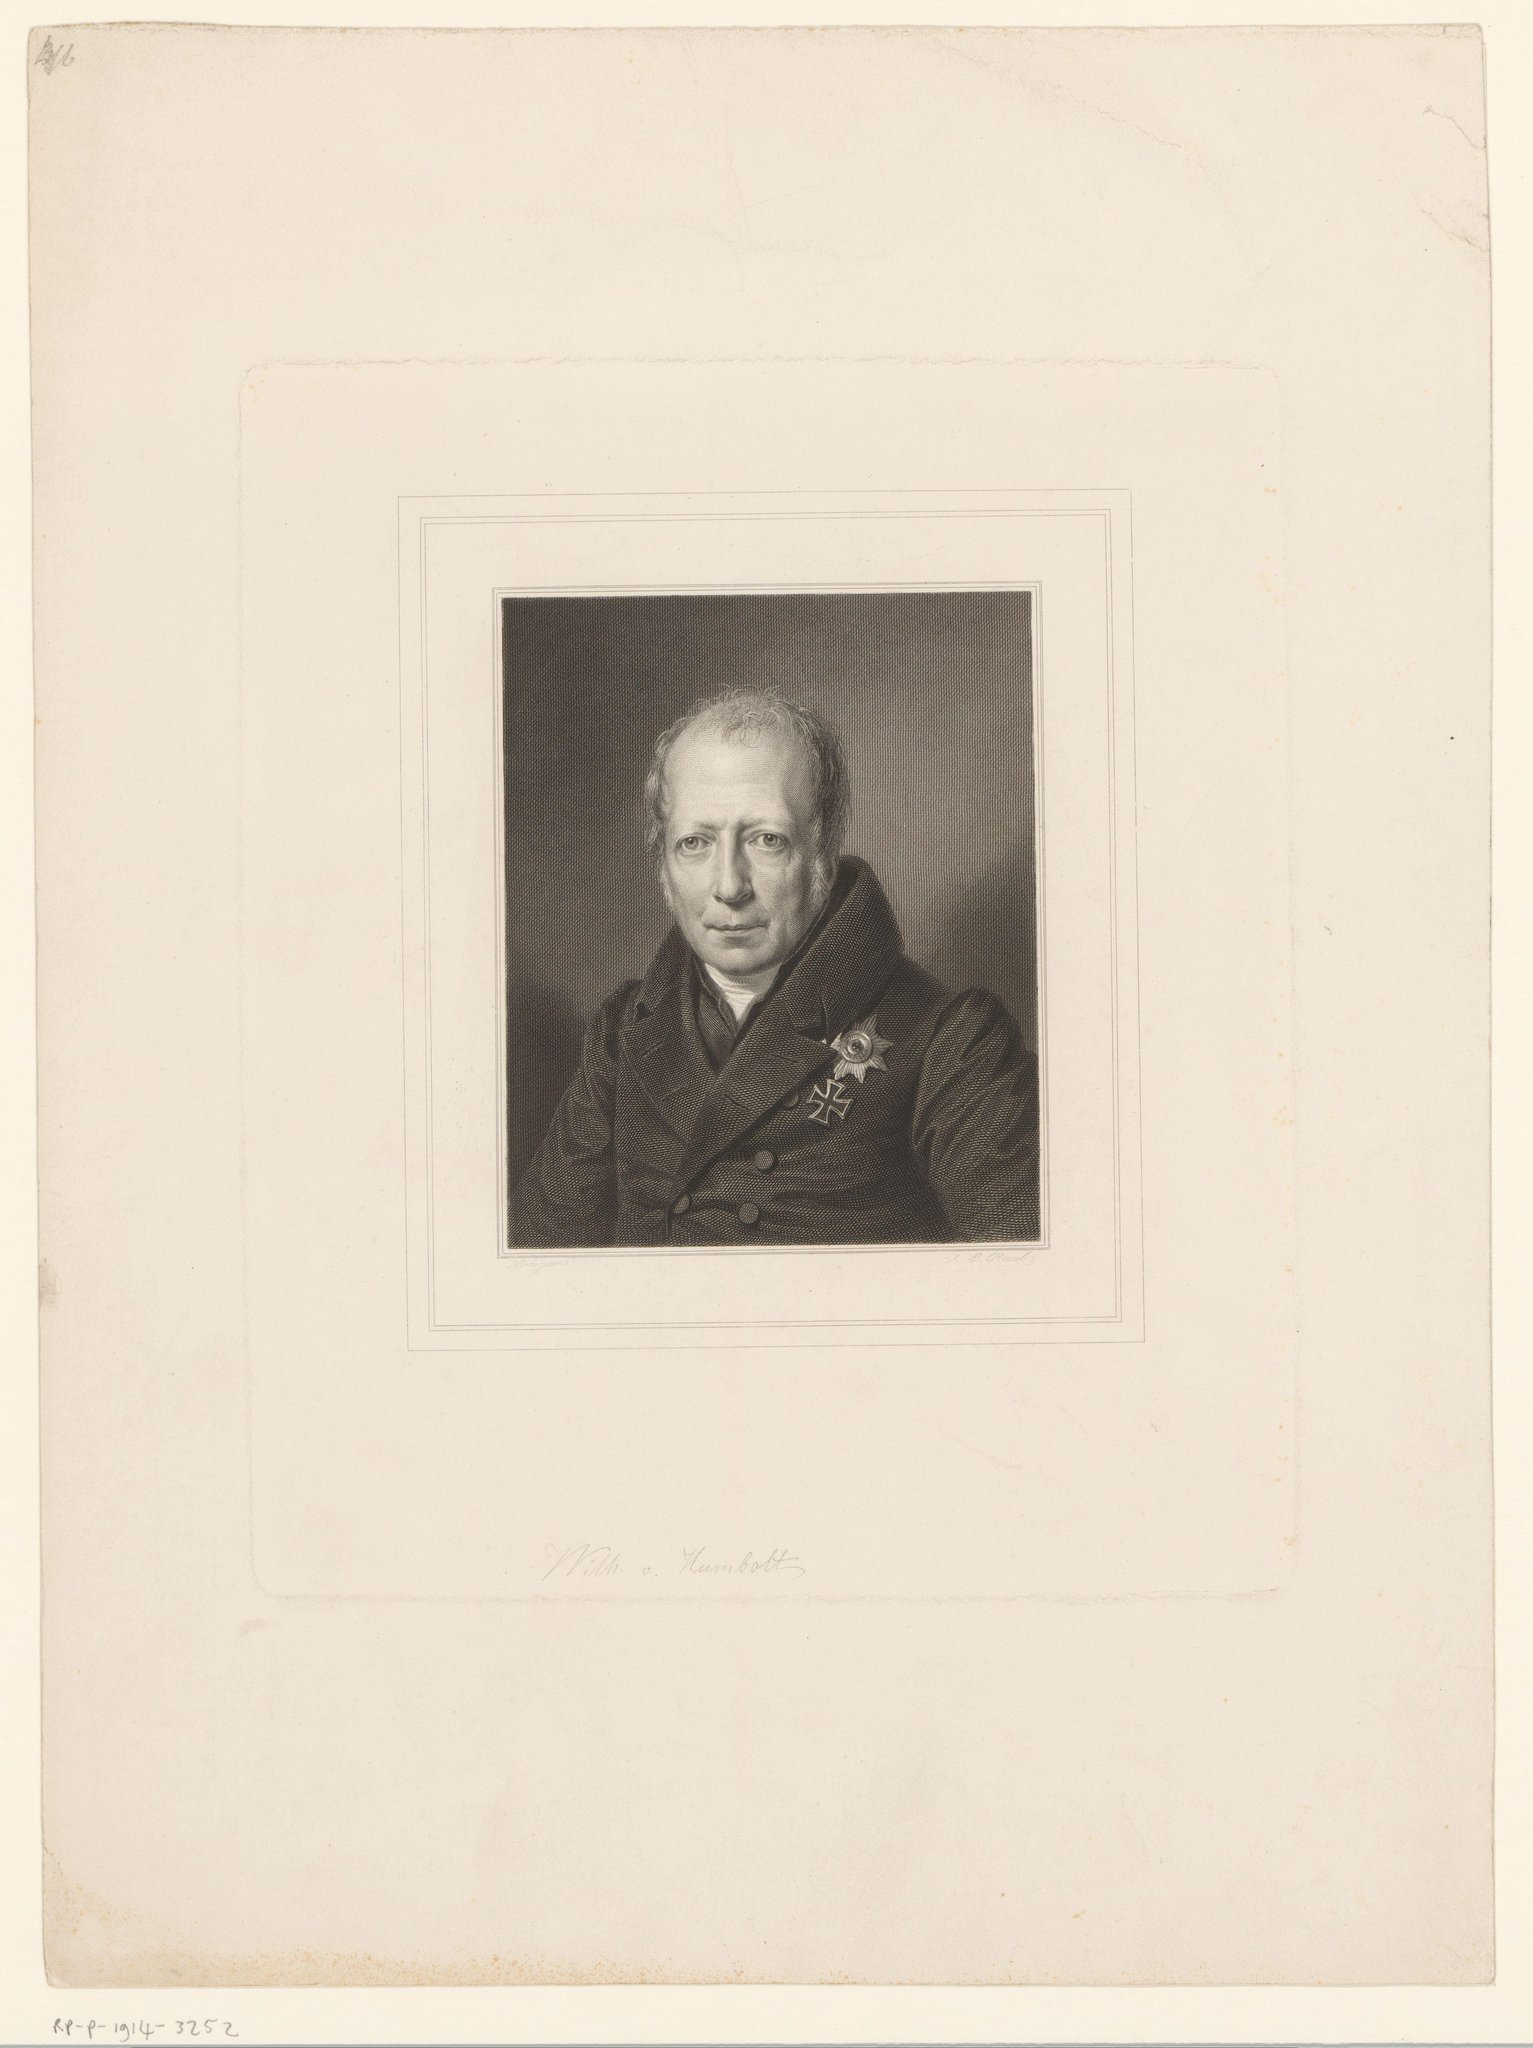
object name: print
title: Portret van Wilhelm von Humbolt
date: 1840-1899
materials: paper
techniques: engraving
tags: knighthood order (red eagle order), historical persons, medals and other marks of military honour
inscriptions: name, collector's mark: Lugt 2228